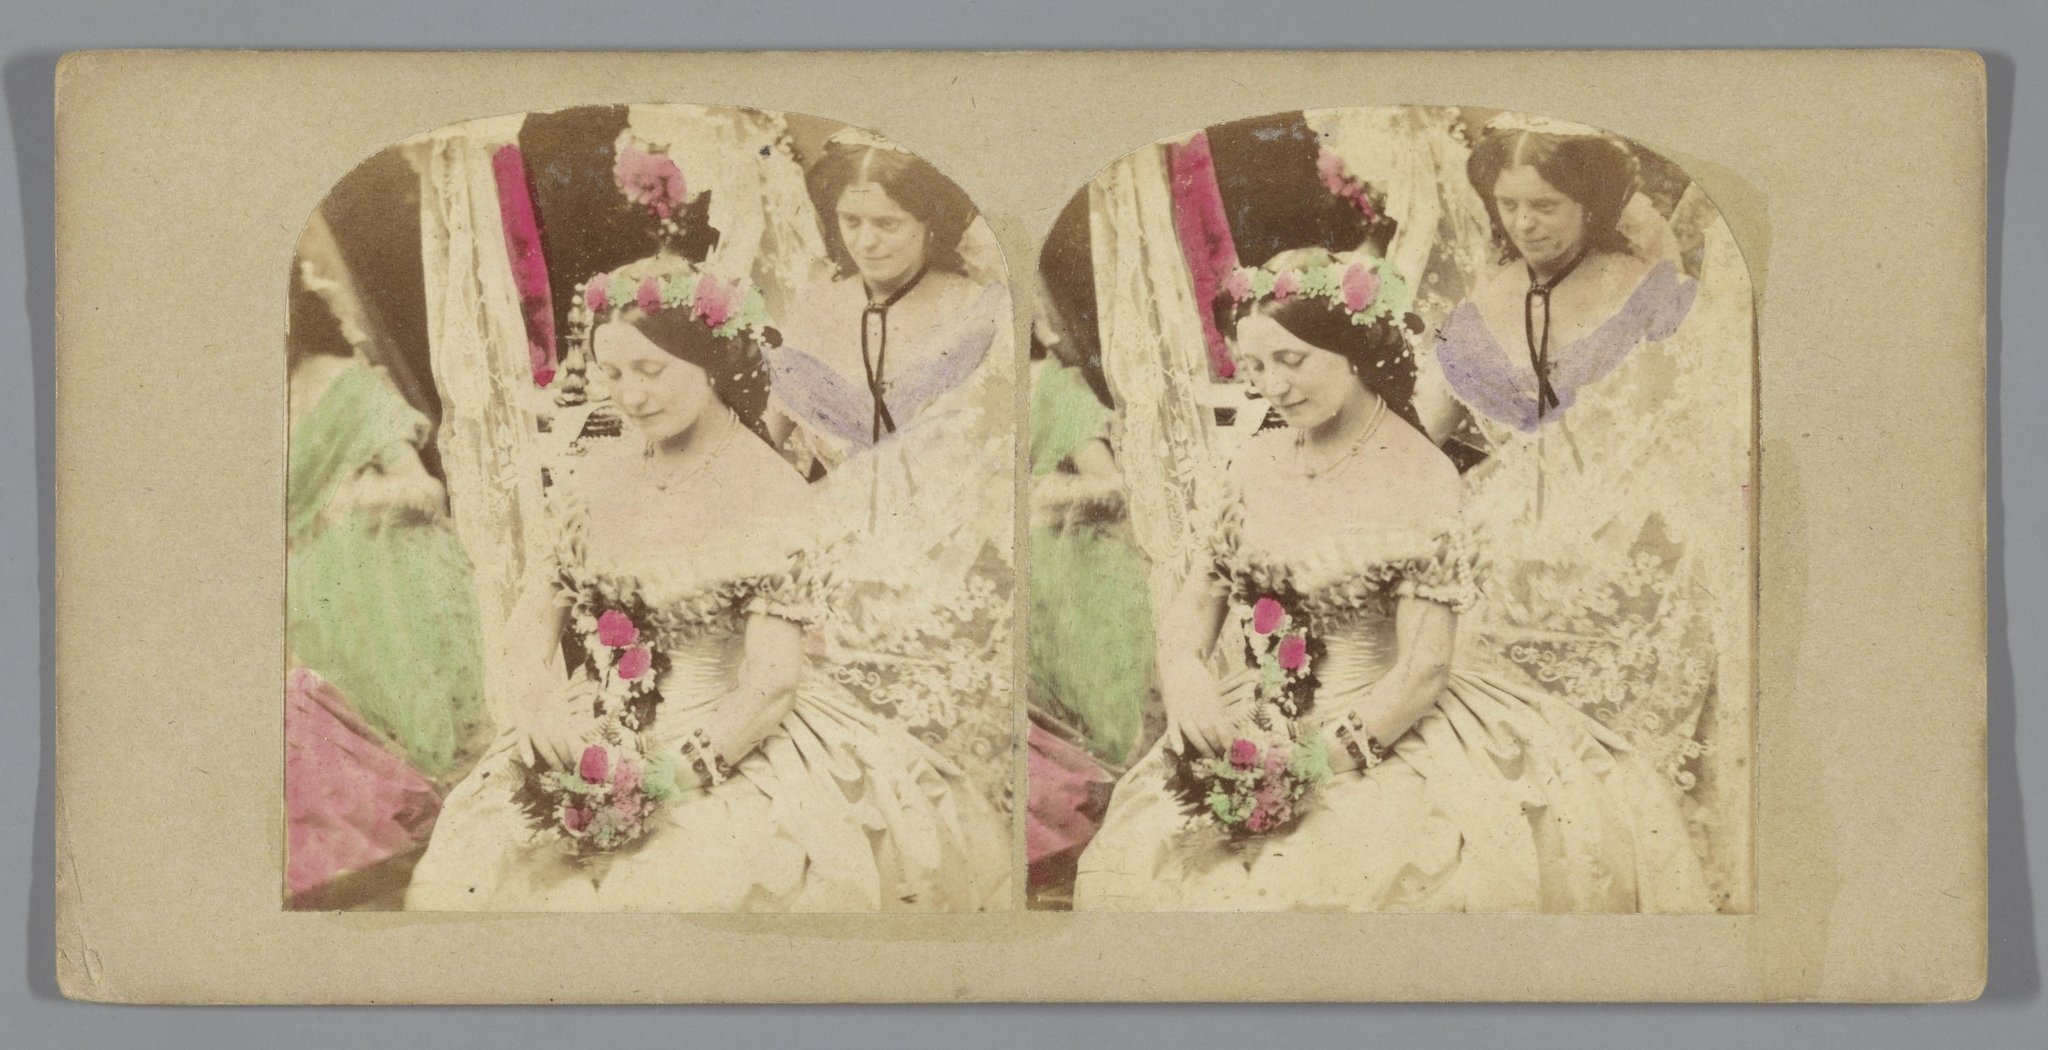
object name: stereograph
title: Bruid met een bruidsmeisje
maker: Anonymous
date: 1852-1863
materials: cardboard, paper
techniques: albumen print, hand coloring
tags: bride (in wedding-dress)